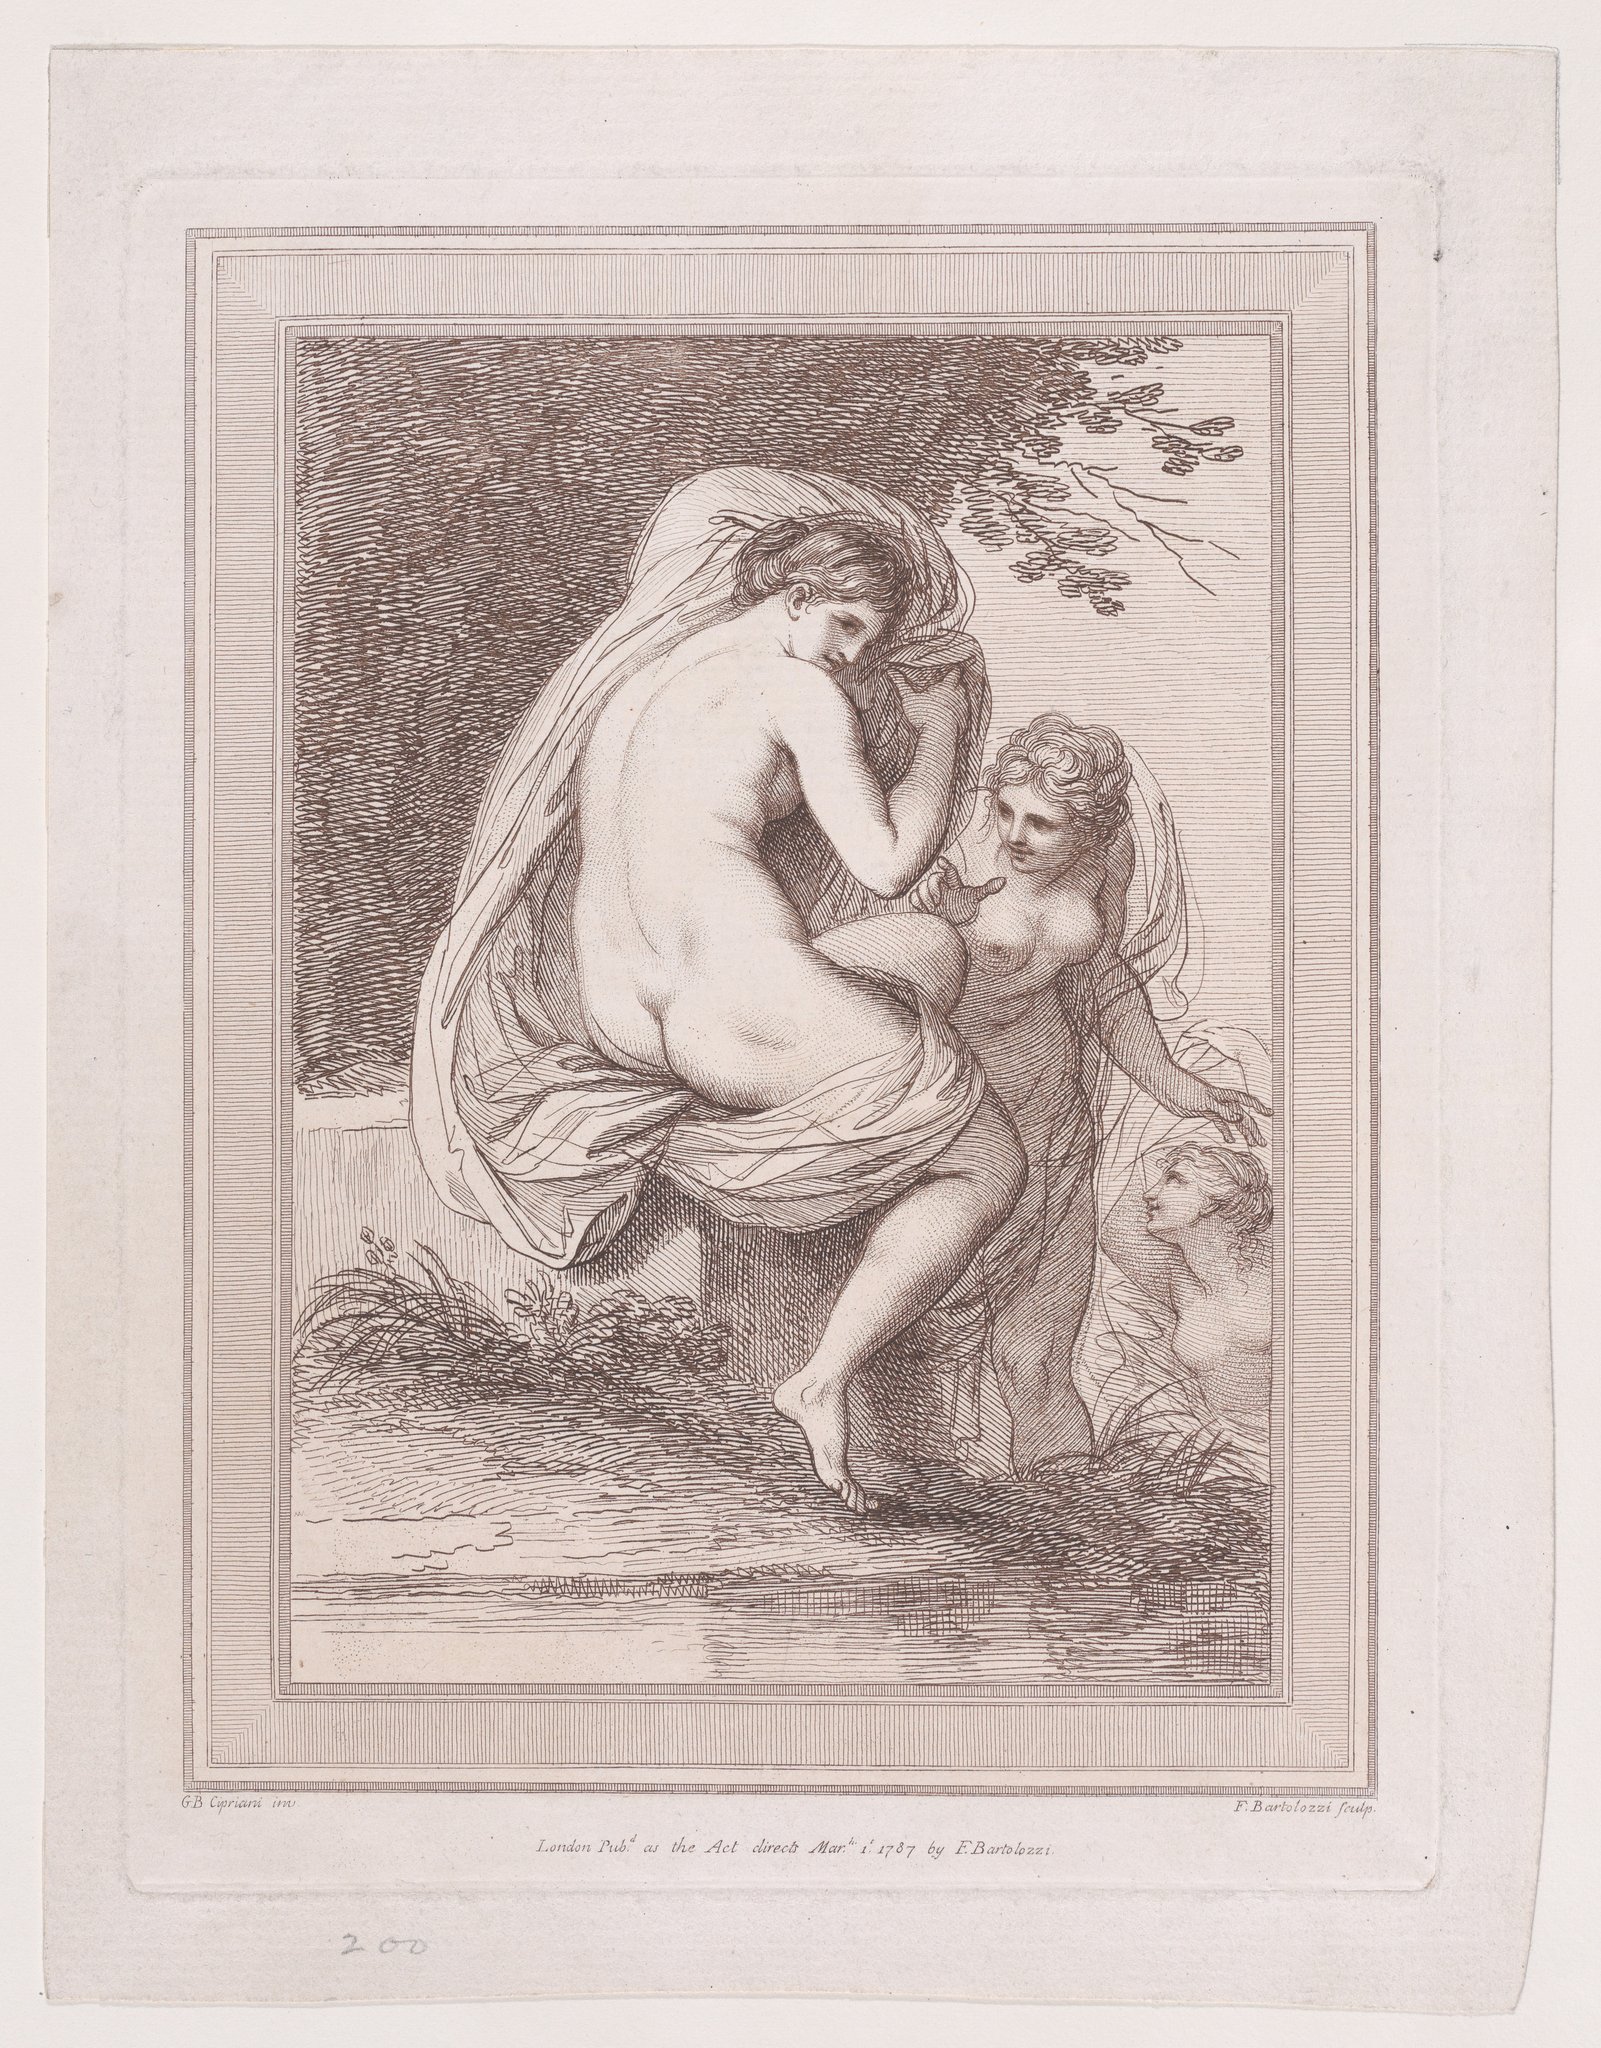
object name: print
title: Three Nymphs Bathing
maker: francesco bartolozzi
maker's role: artist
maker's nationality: italian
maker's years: 1728-1815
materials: ink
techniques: engraving, etching, printing